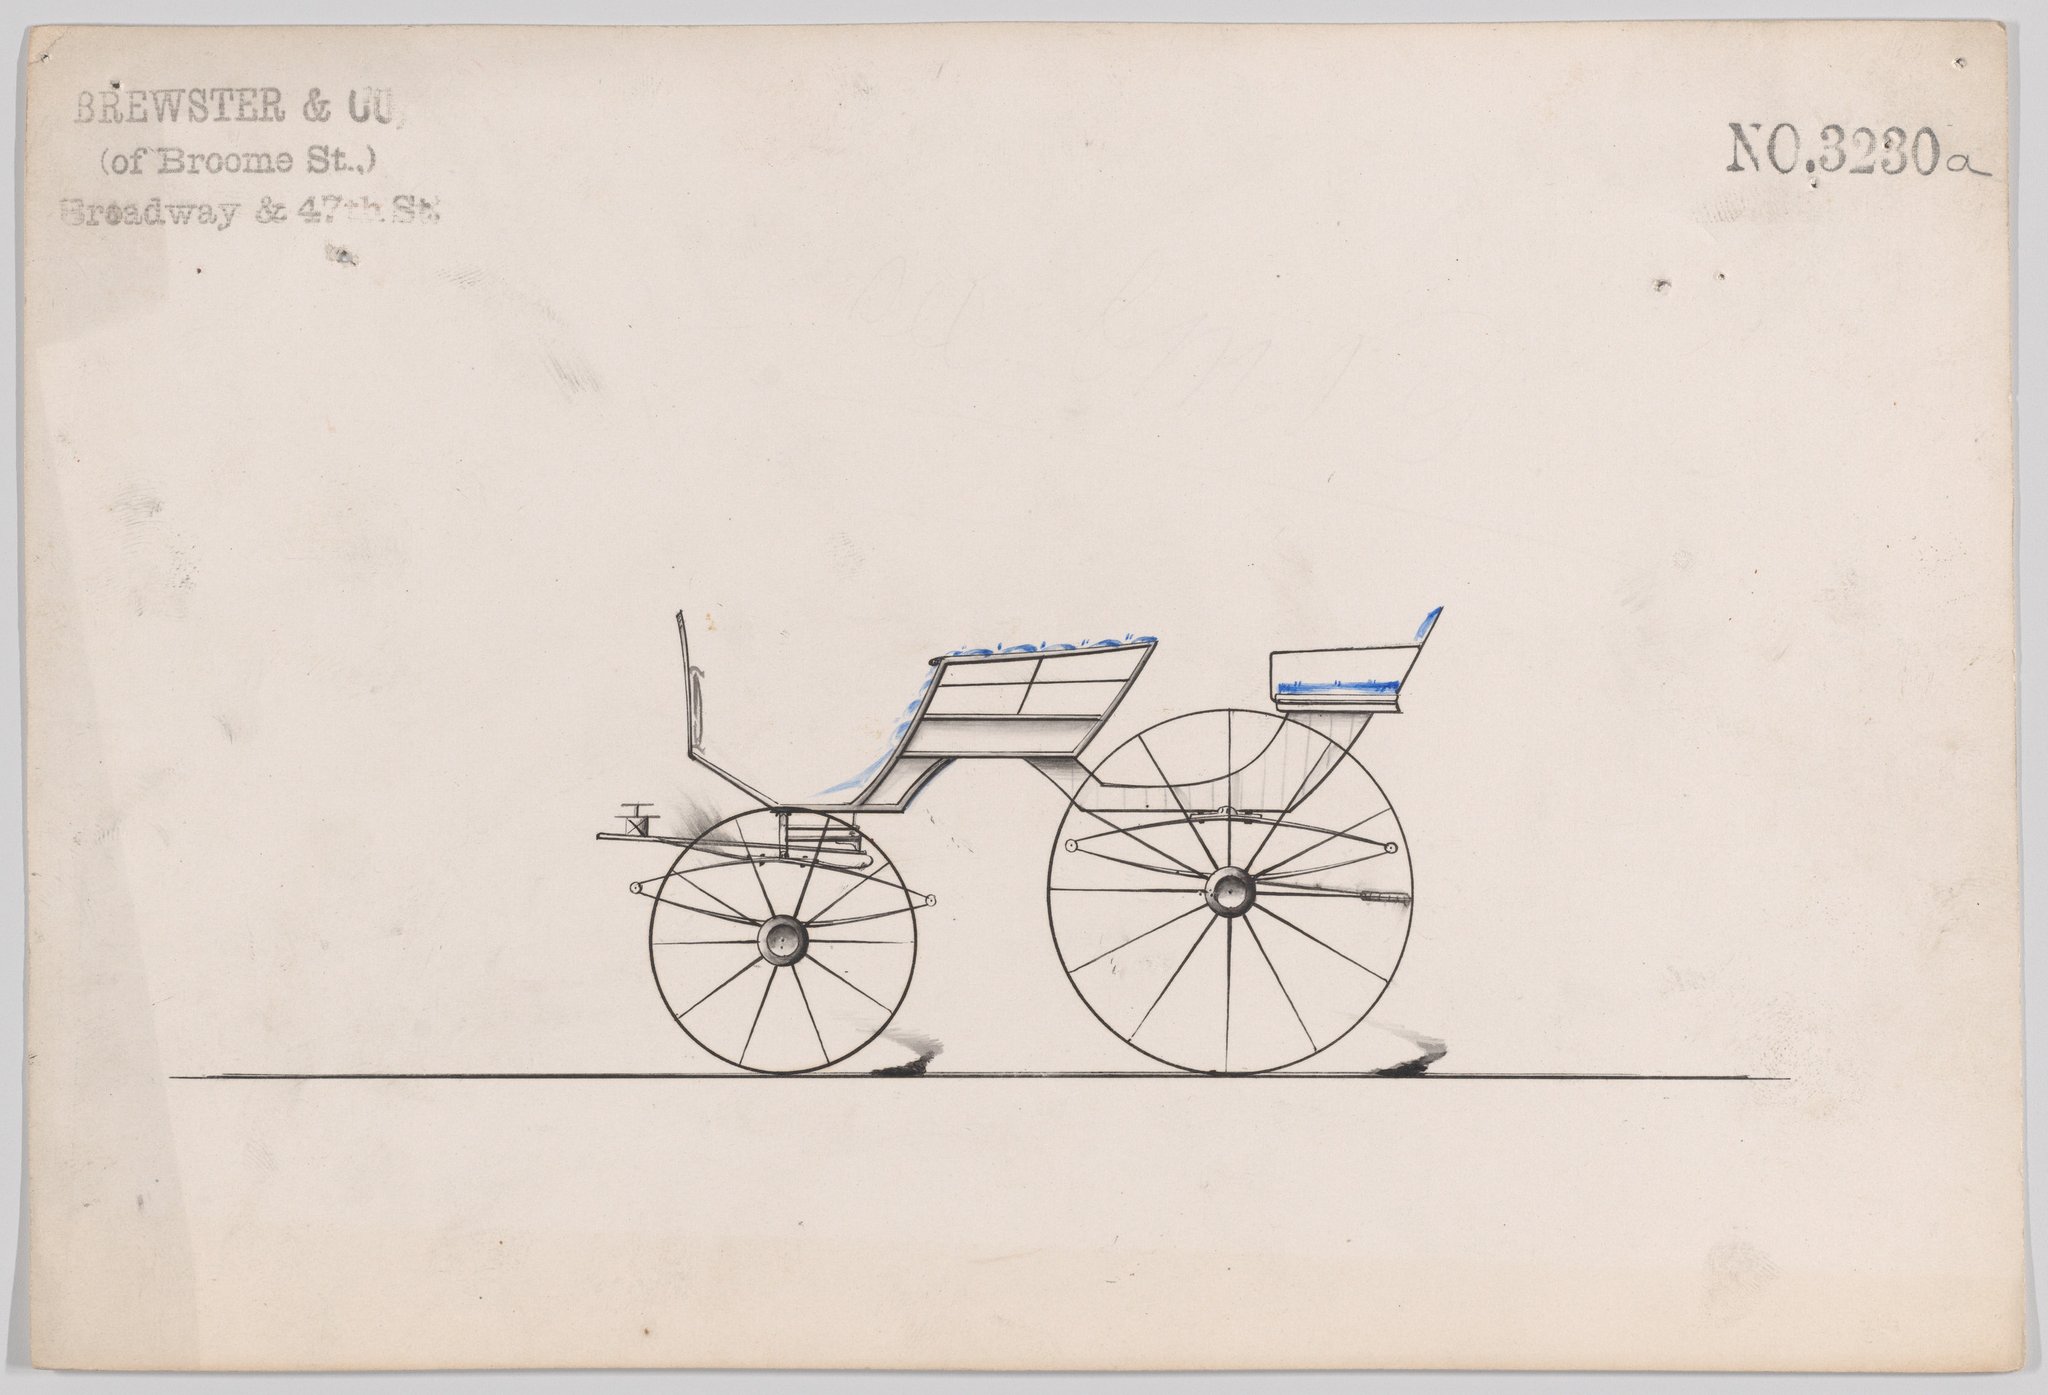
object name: drawing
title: Design for Pony Phaeton, no. 3230a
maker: brewster & co.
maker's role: manufacturer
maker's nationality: american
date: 1876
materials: gouache, ink, watercolor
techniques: pen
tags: carriages